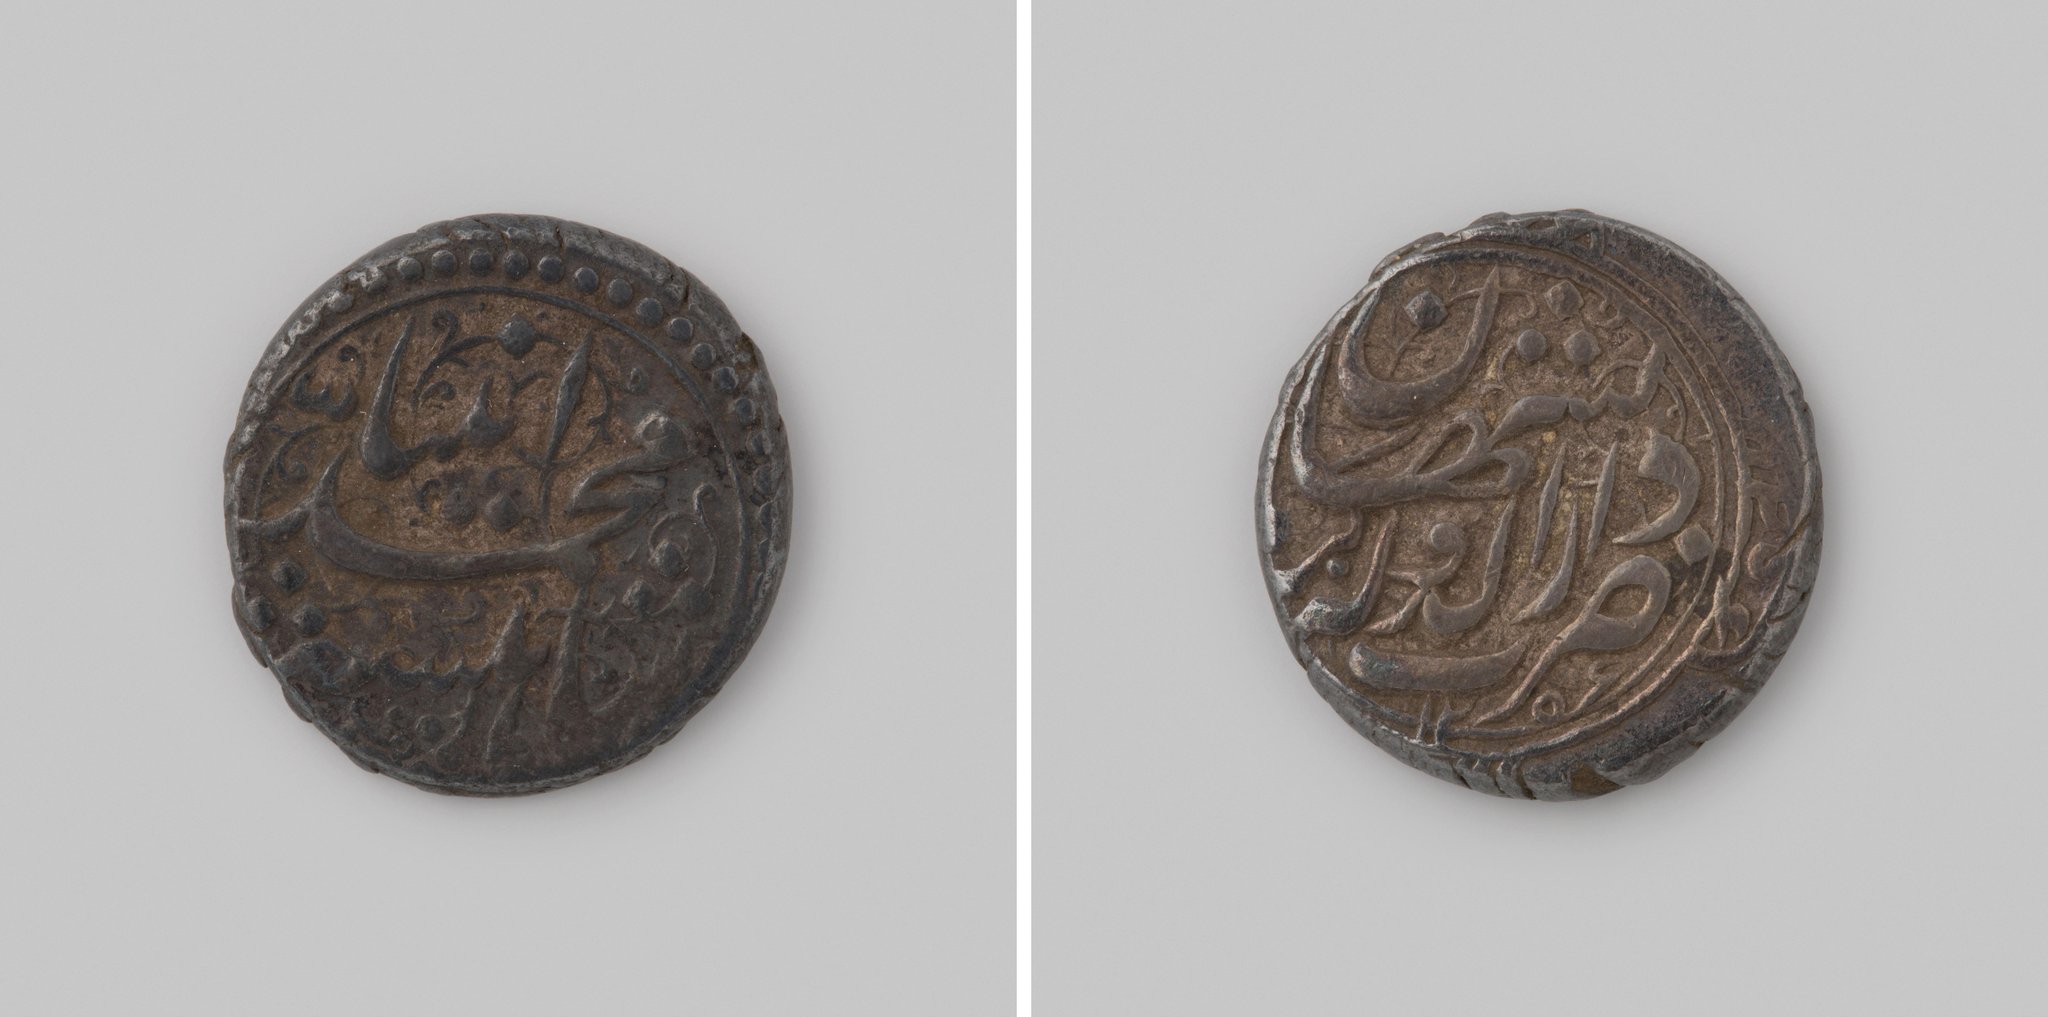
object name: coin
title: Kran uit Perzië van Mohammed Shah, 1250-1264 AH [=1835-1848], 1256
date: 1841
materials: silver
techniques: striking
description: Zilveren munt. Voorzijde: in Arabische lettertekens opschrift in drie regels: naam van de shah. Keerzijde: binnen cirkel in Arabische lettertekens in drie regels regel muntplaats-aanduiding: Kermanshahan. Daaronder jaartal: 1256. Rondom cirkel in Arabische lettertekens omschrift. Gladde rand.